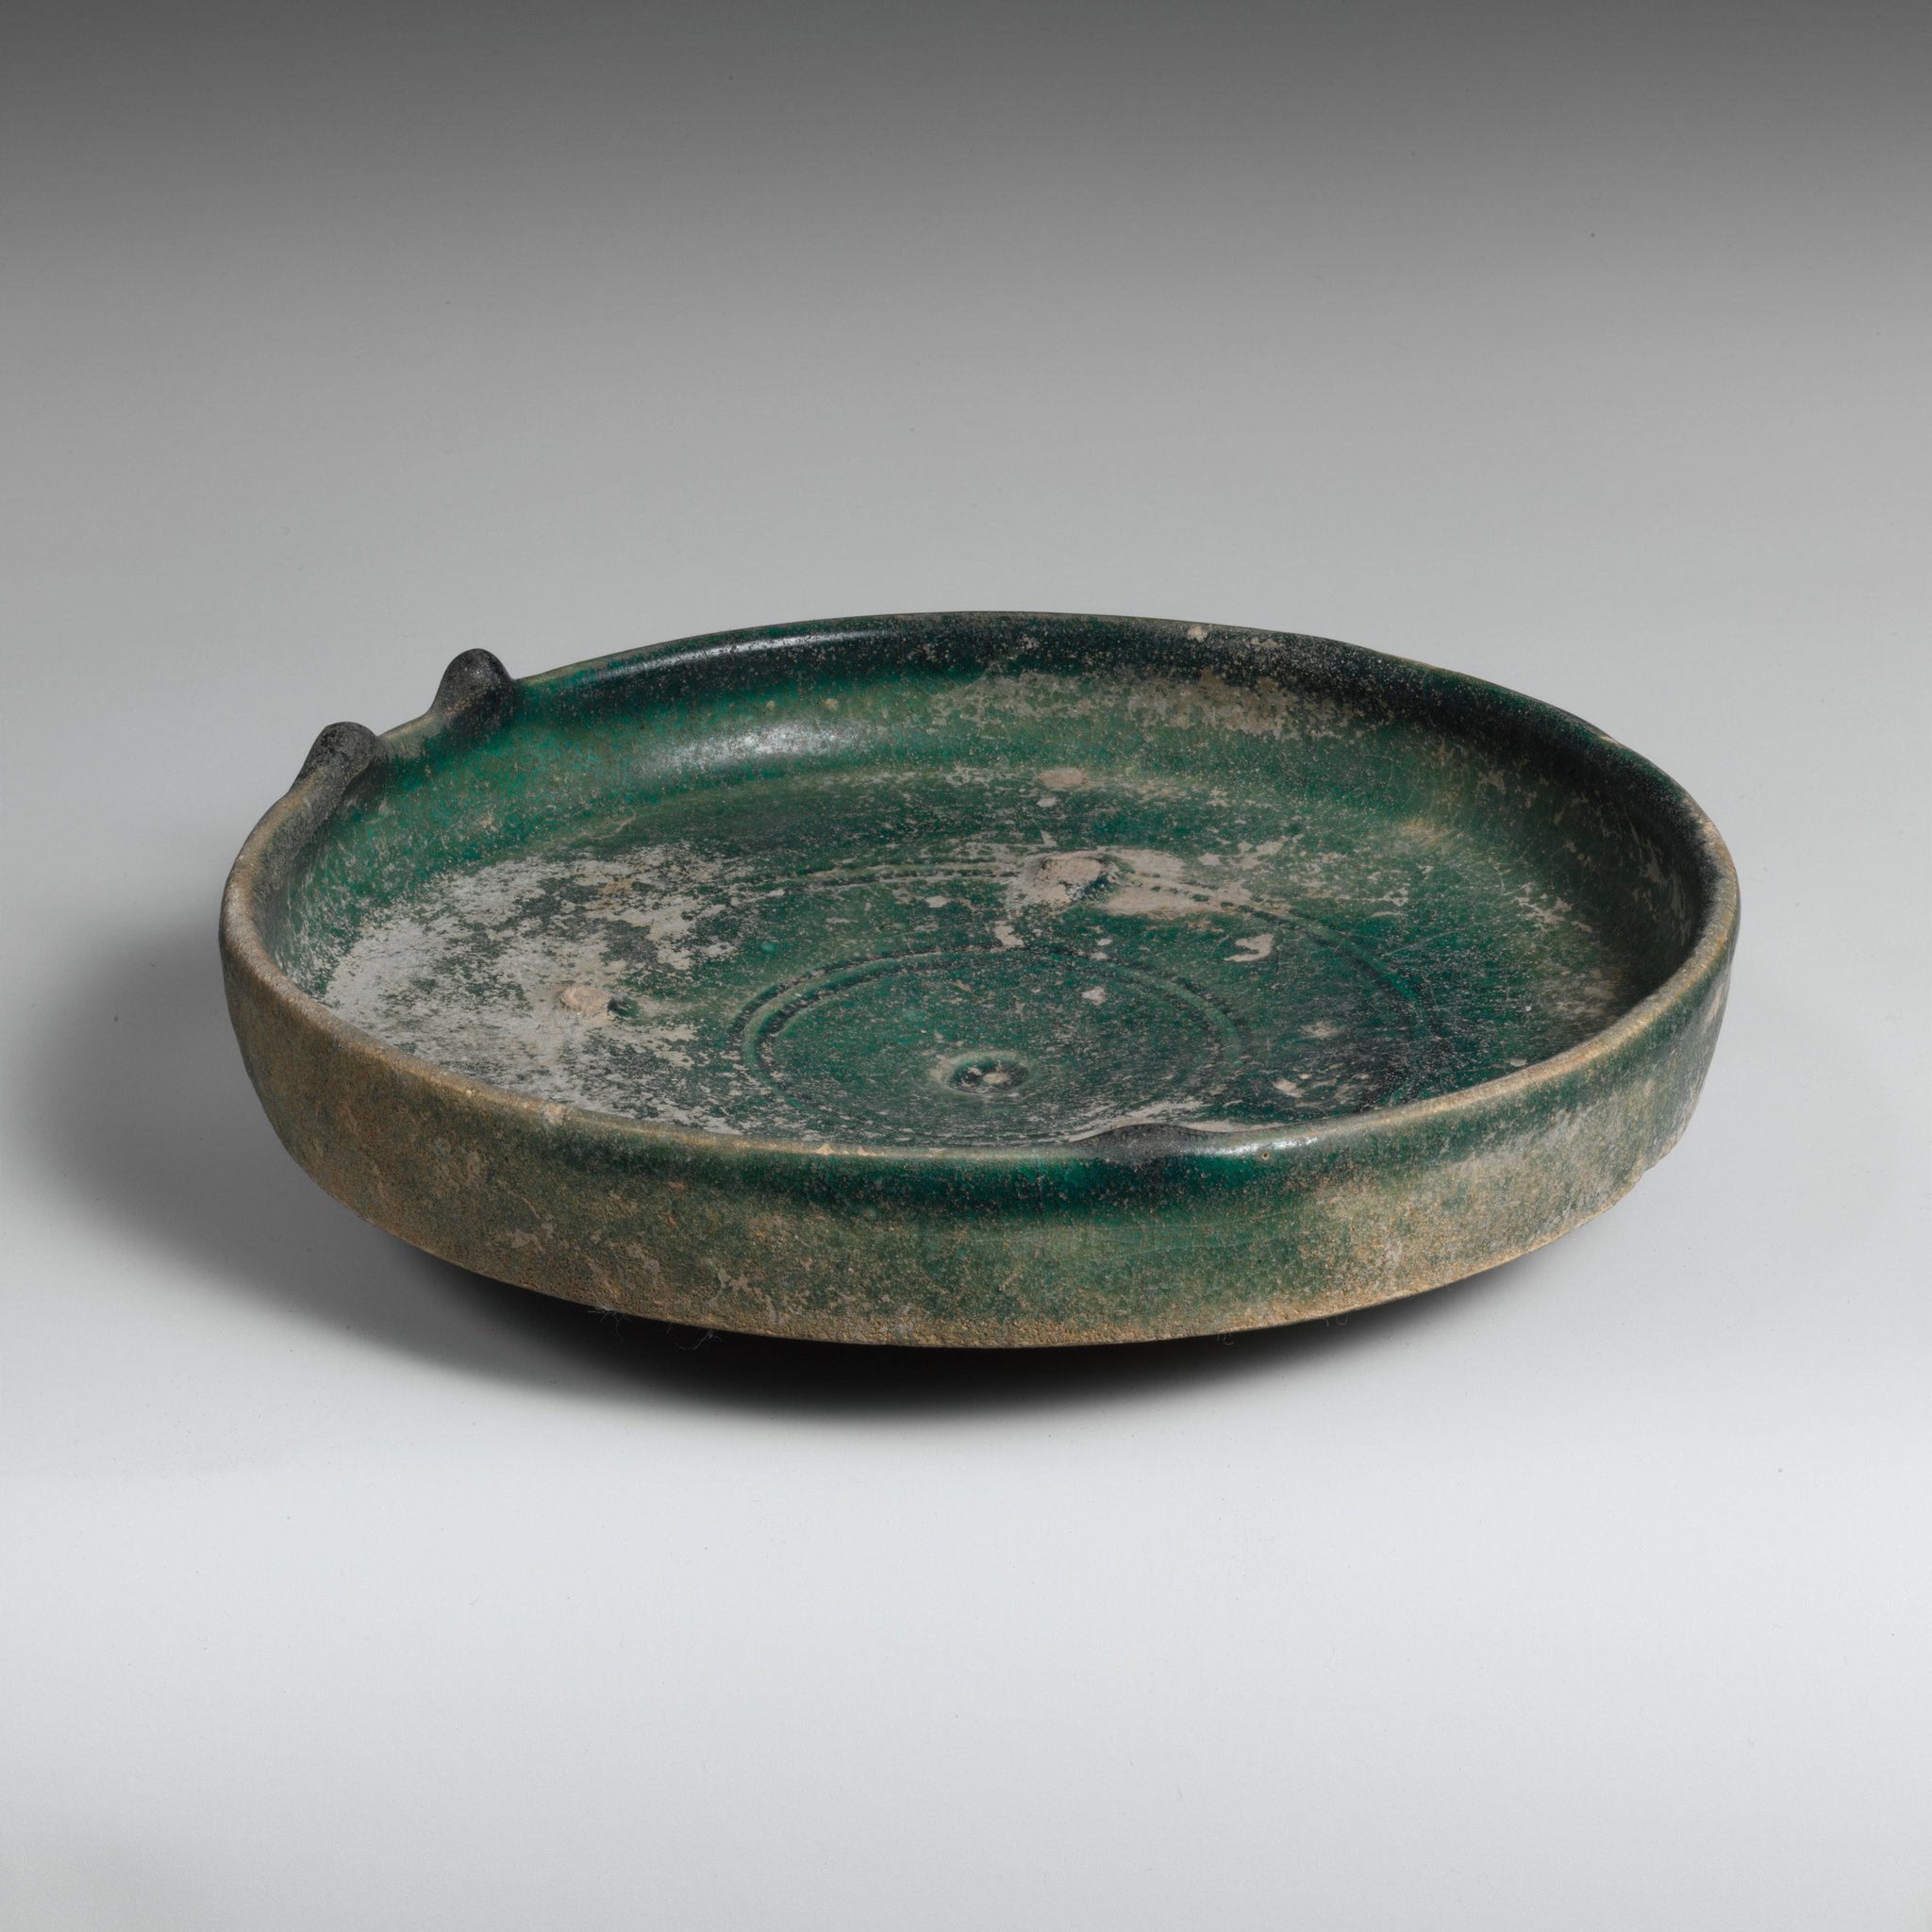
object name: plate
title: Terracotta dish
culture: roman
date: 100 BCE-100 CE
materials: terracotta